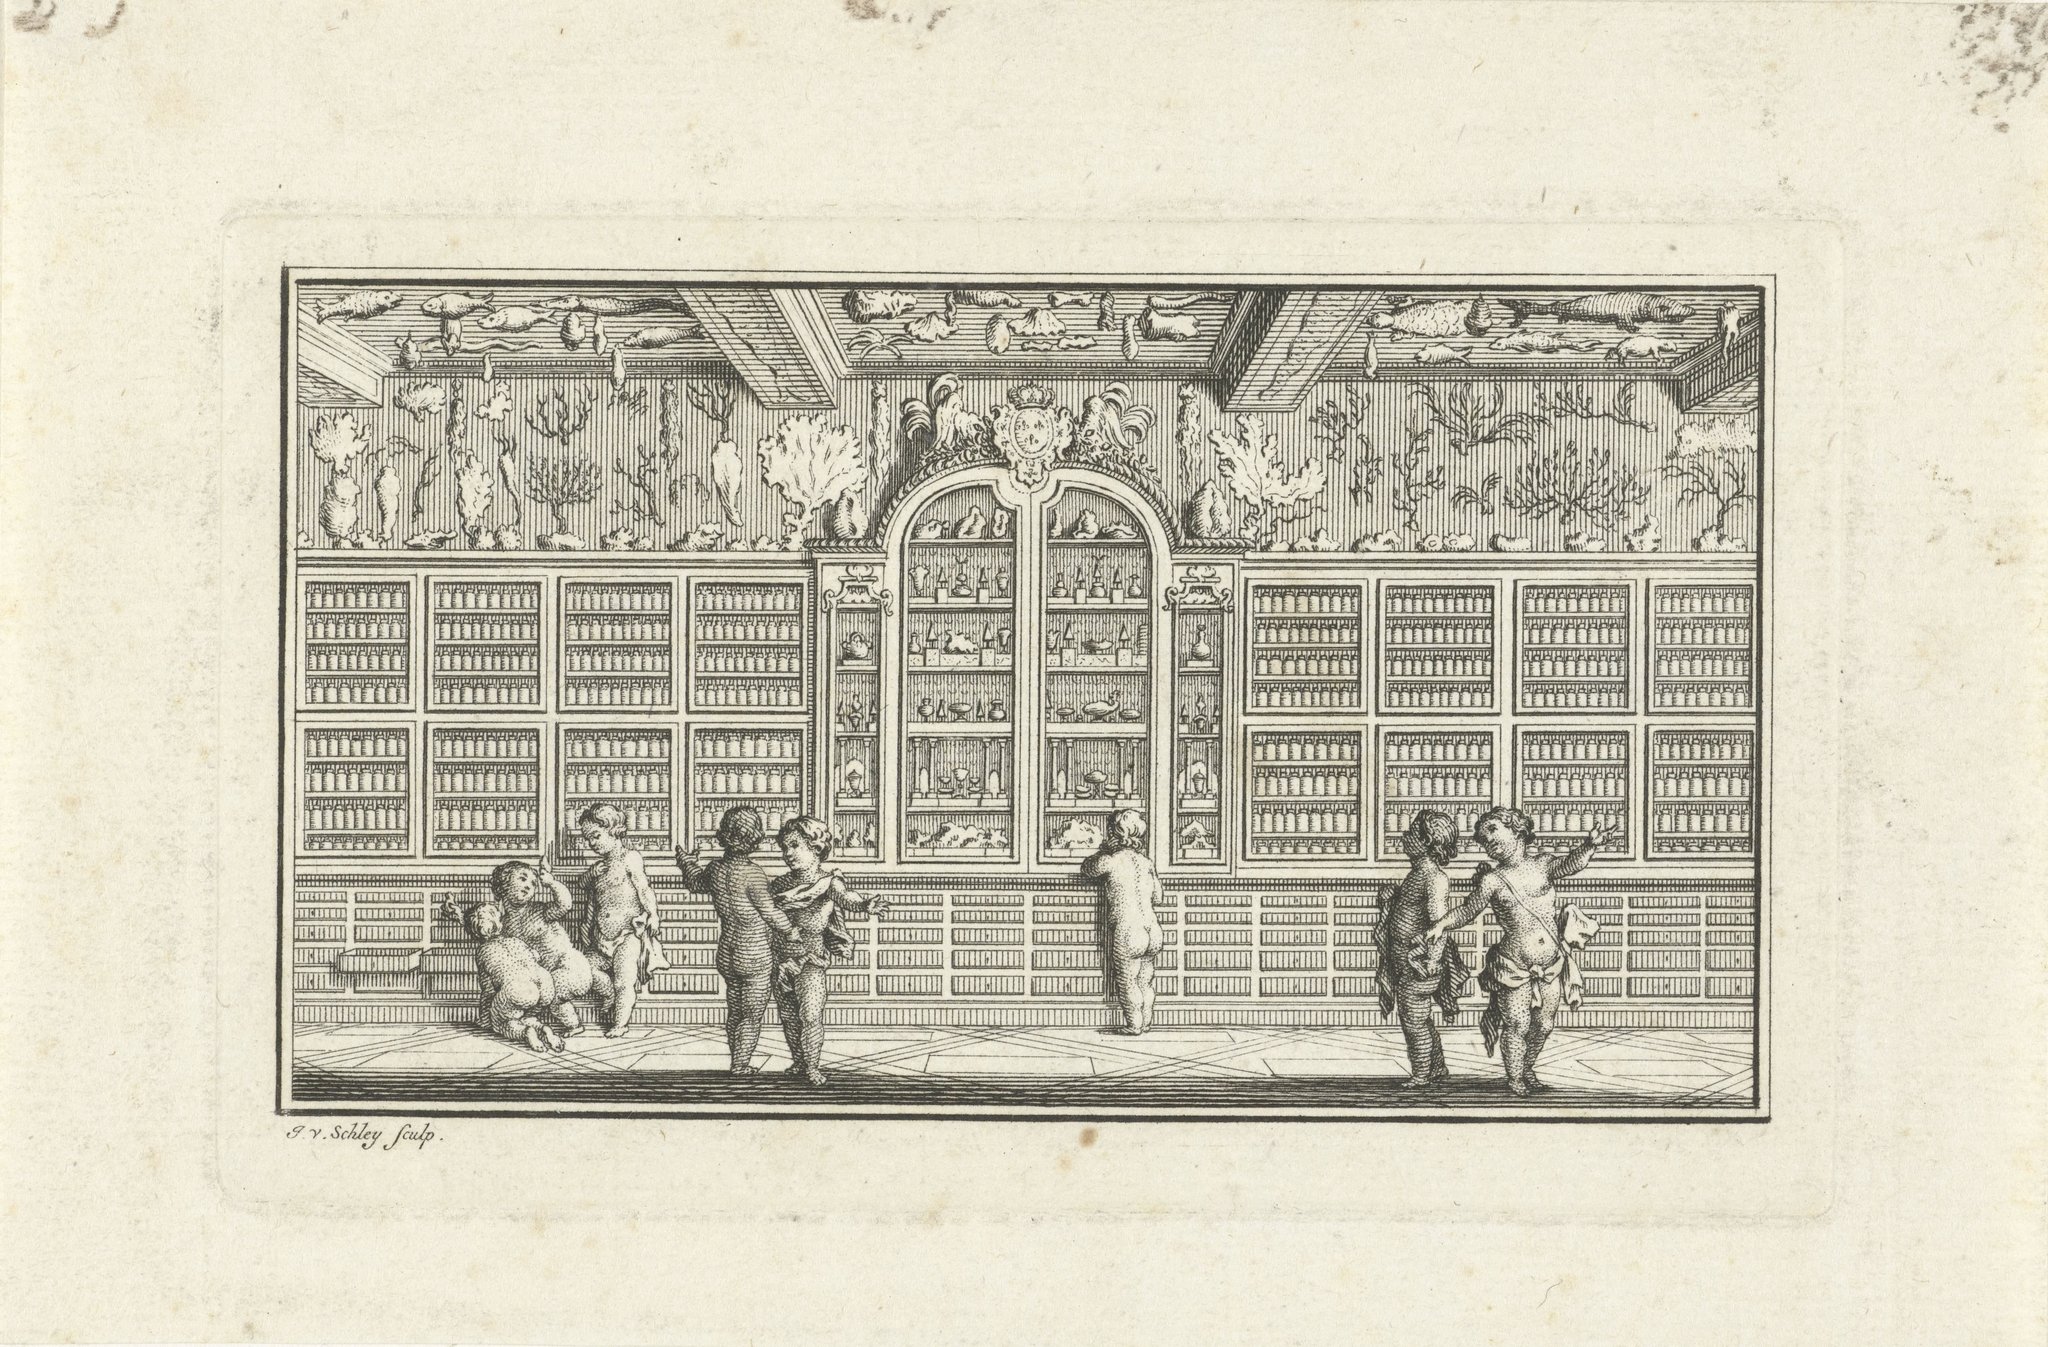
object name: print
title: Rariteitenkabinet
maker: jacob van der schley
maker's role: draughtsman, print maker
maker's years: 1715-1779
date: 1725-1779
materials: paper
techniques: engraving, etching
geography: amsterdam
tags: cabinet of curiosities, 'kunst- und wunderkammer', cupids: 'amores', 'amoretti', 'putti'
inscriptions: collector's mark: Lugt 2228, collector's mark: Lugt 2760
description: Acht putti bewonderen een rariteitenkabinet.